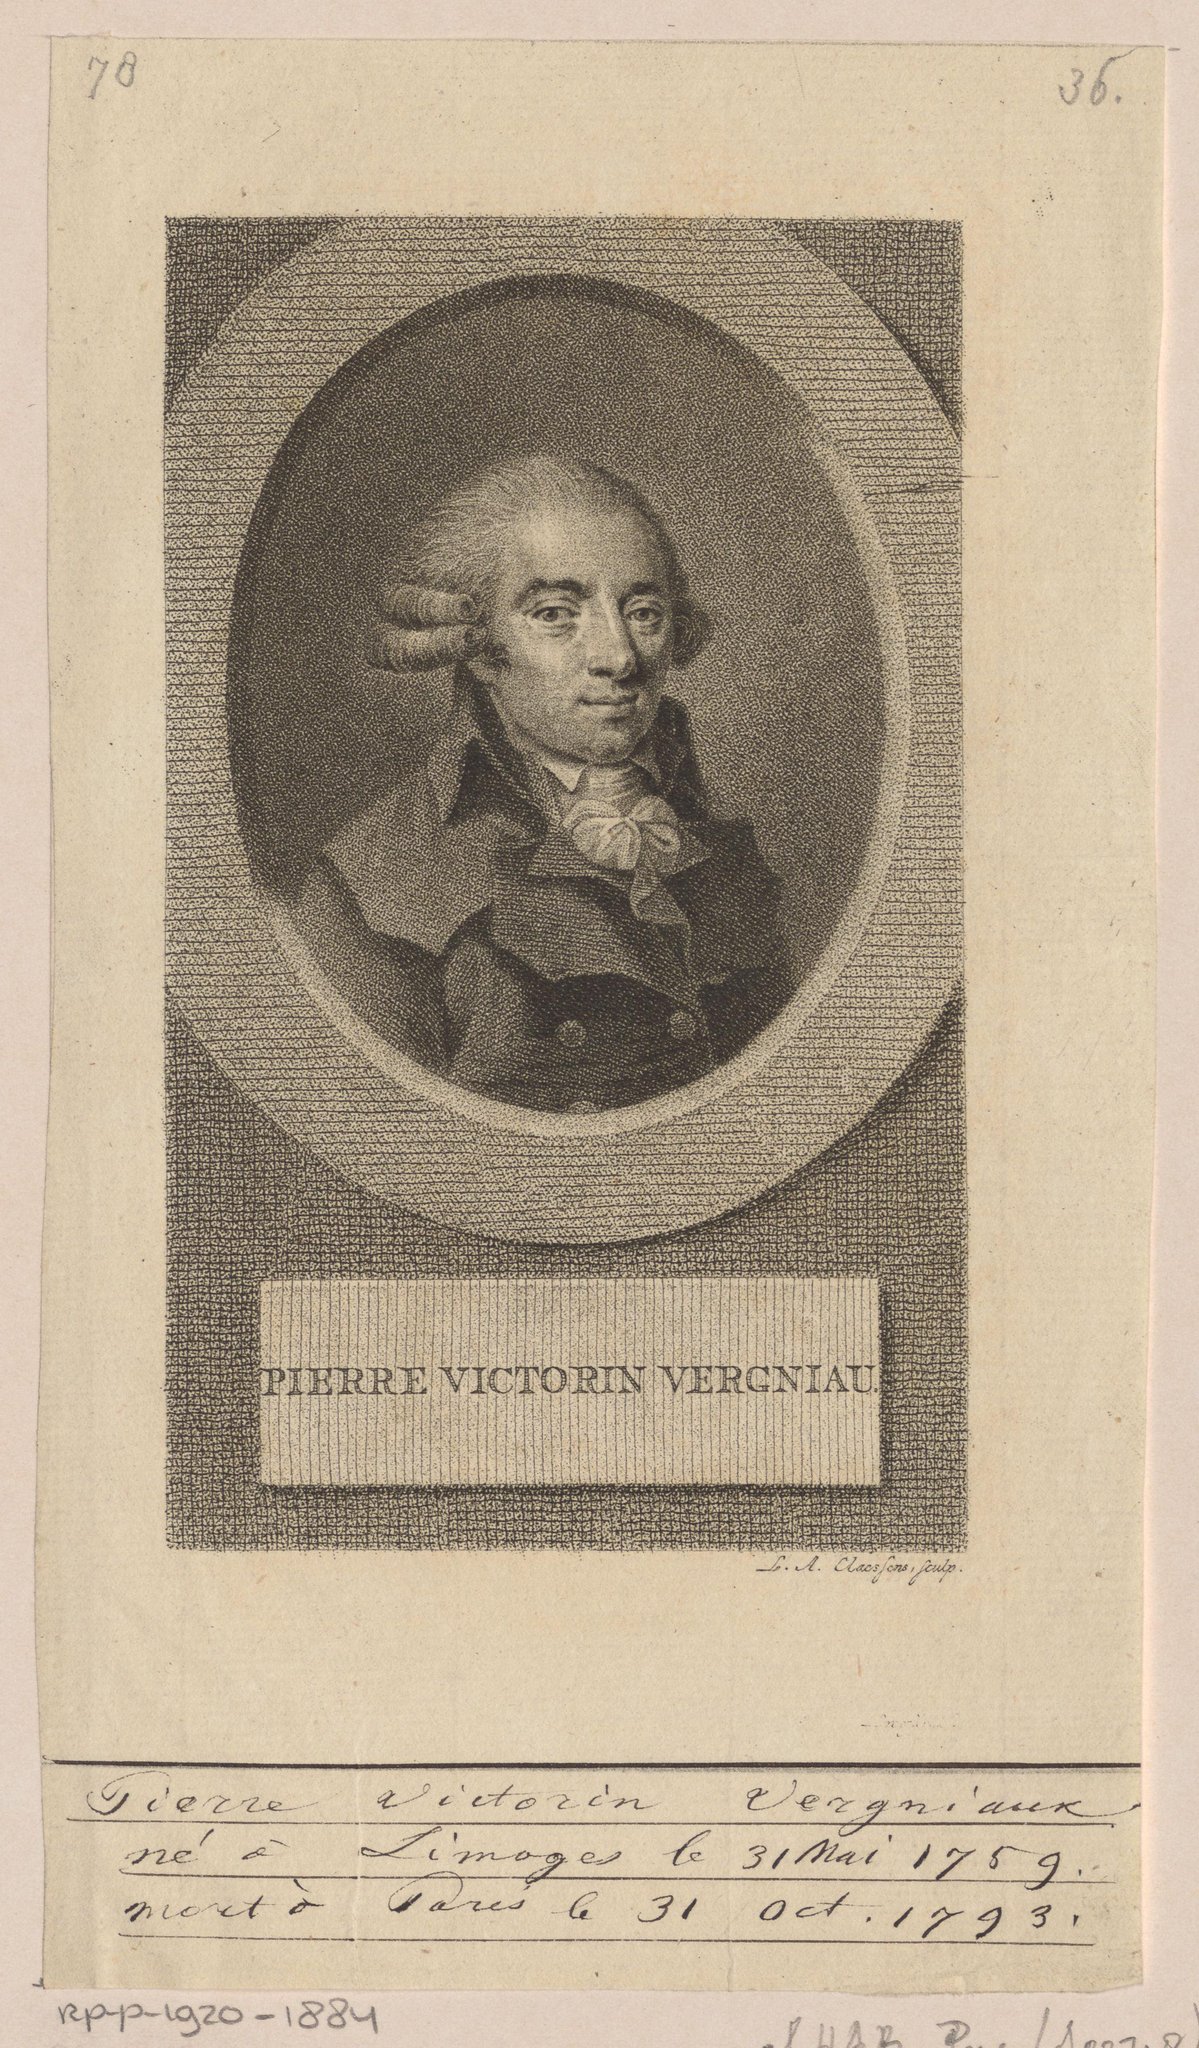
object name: print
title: Portret van Pierre Victurnien Vergniaud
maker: lambertus antonius claessens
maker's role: draughtsman, print maker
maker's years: 1763-1834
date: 1800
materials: paper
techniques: etching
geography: southern netherlands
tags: politician, historical persons, politician, e.g. party leader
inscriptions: collector's mark: Lugt 2228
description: Prent waarschijnlijk uit: Tafereelen van de staatsomwenteling in Frankrijk. Amsterdam: Johannes Allart, 1800, dl. 11.